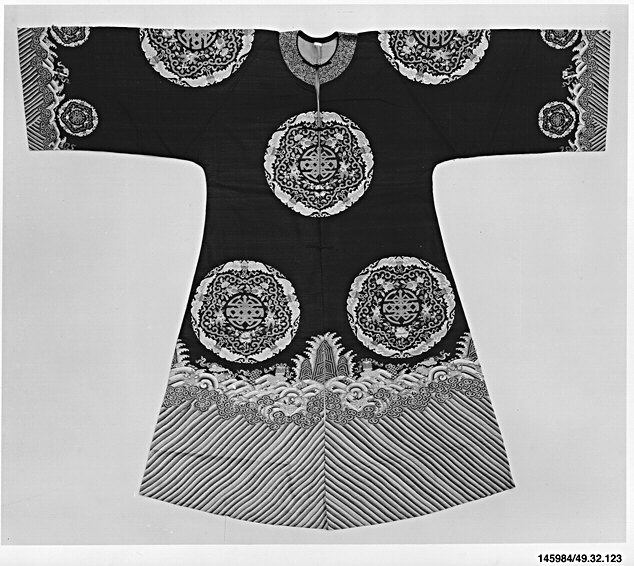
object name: coat, ceremonial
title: Ceremonial Coat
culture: chinese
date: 1767-1833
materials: metal thread, silk